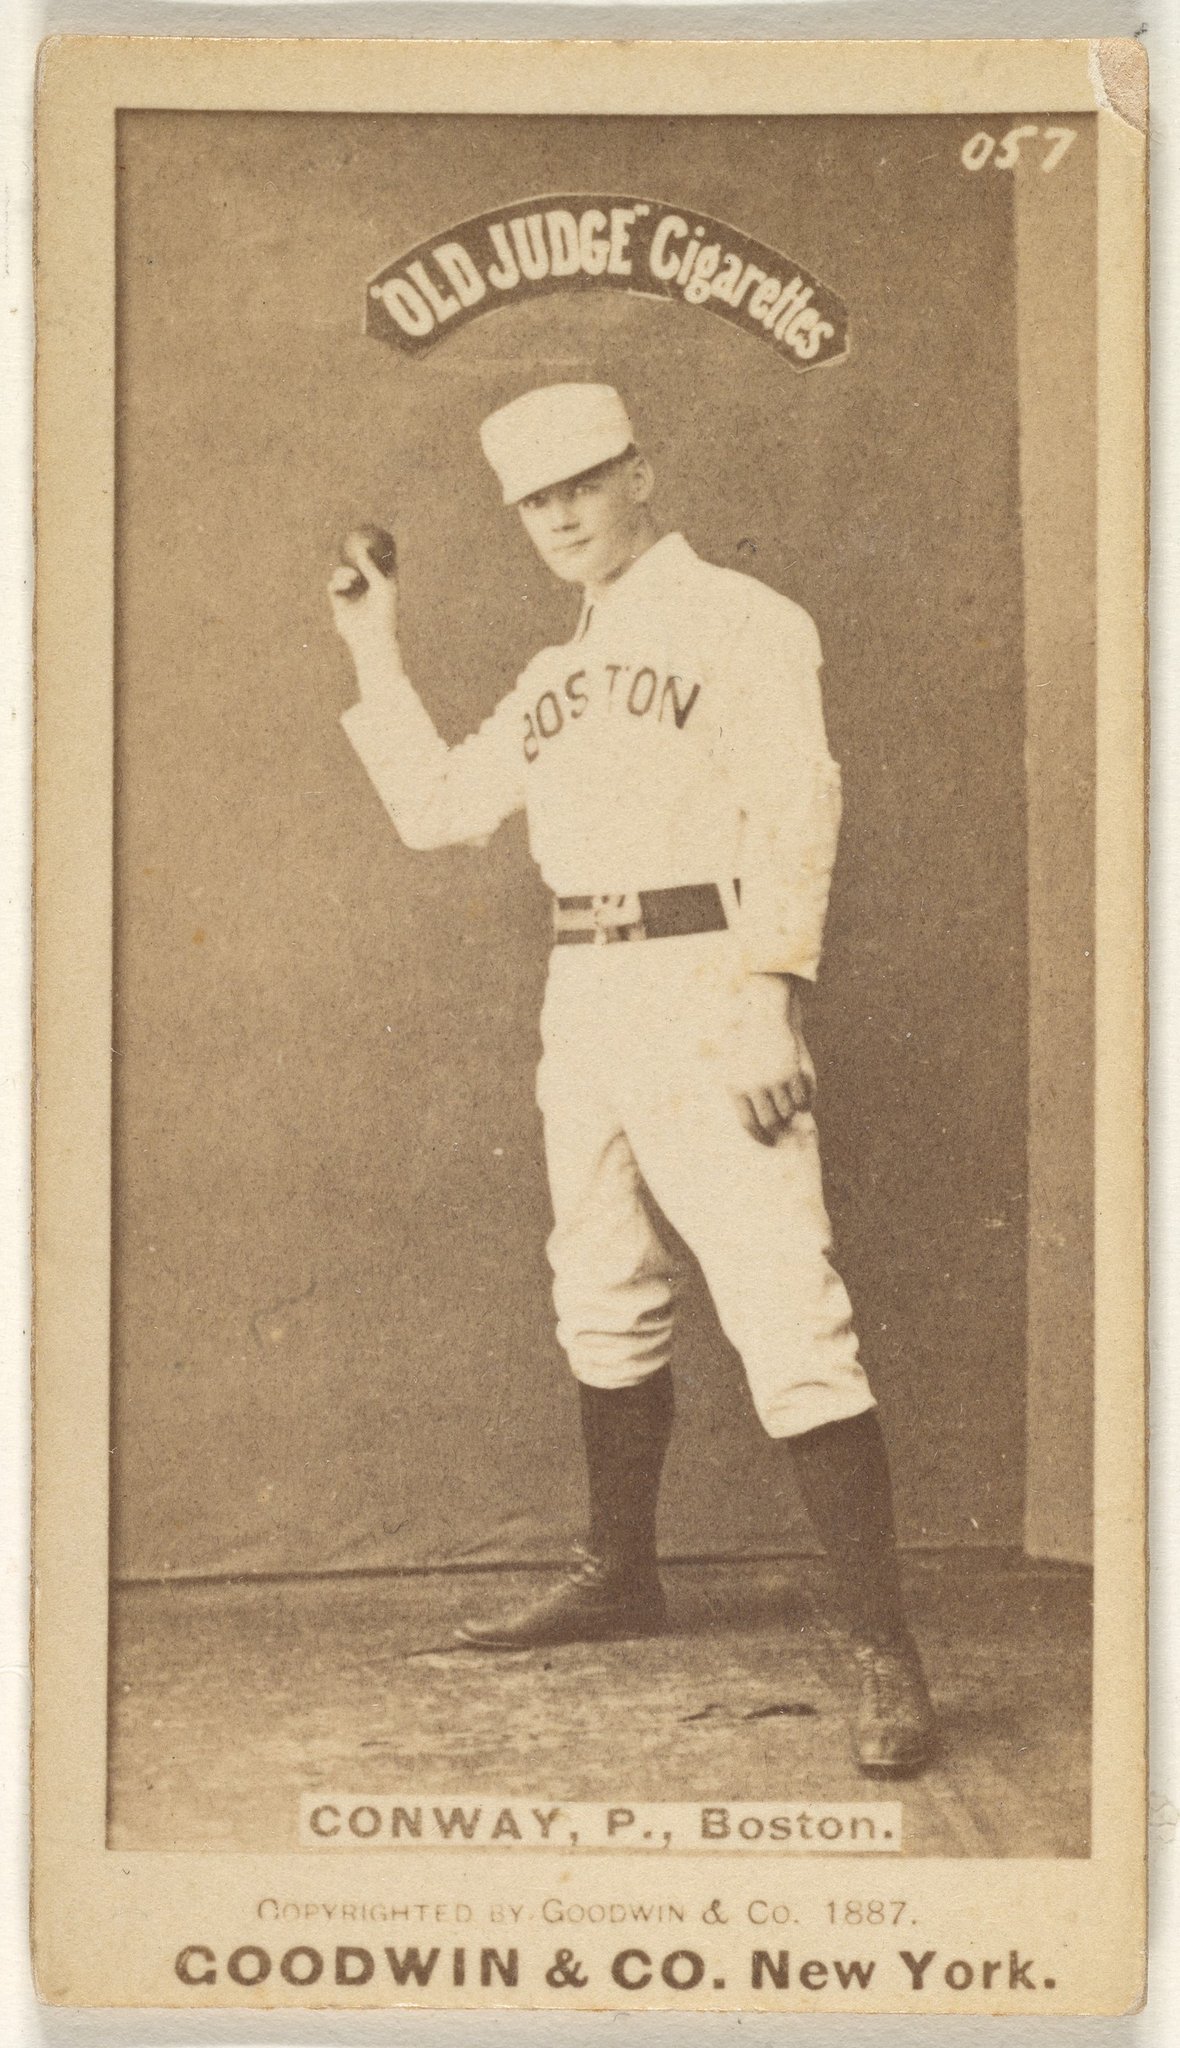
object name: baseball card, photograph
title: Conway, Pitcher, Boston, from the Old Judge series (N172) for Old Judge Cigarettes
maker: goodwin & company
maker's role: publisher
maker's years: 1850-1950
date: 1887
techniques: albumen silver print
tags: men,portraits,baseball,athletes